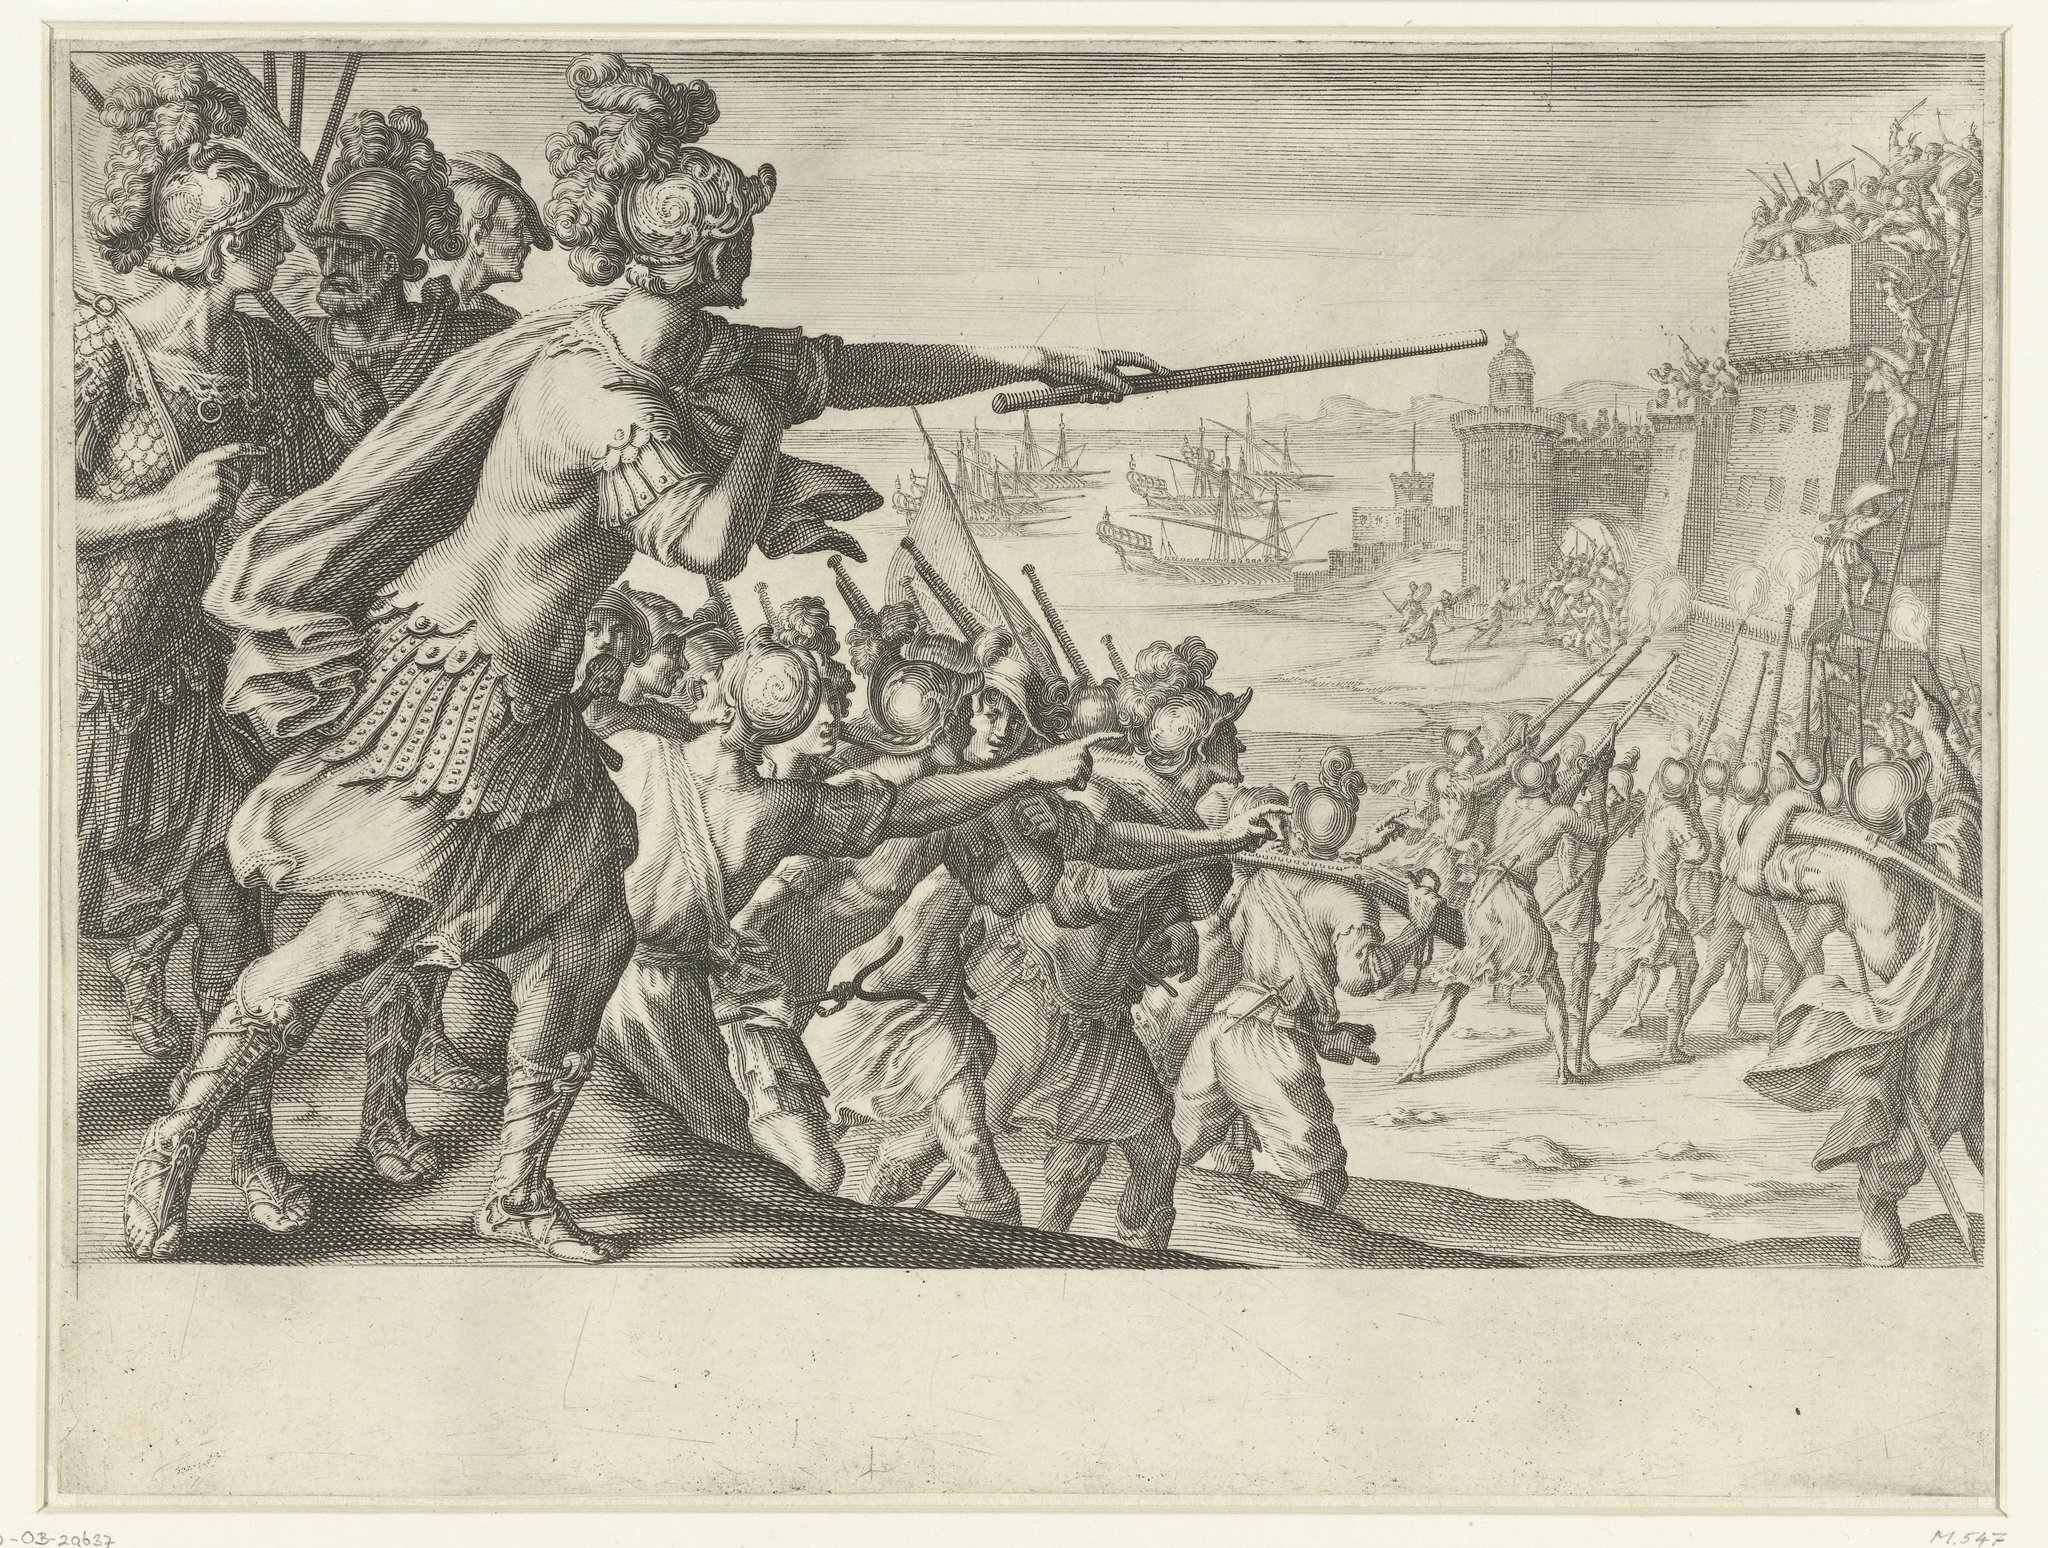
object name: print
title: Aanval van de troepen van Ferdinando I de' Medici op de Noord-Afrikaanse stad Bone (Annaba)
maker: jacques callot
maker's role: draughtsman, print maker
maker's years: 1592-1635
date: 1614-1620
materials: paper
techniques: engraving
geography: florence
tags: ferdinando i de' medici, asiatic races and peoples: turks, walls ~ fortified city, (military) attack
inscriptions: collector's mark: Lugt 240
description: De aanvoerder van de troepen van Ferdinando I de' Medici, links op de voorgrond, wijst met zijn aanvoerdersstaf naar een stadsmuur, die bestormd wordt door zijn manschappen. Onder de voorstelling een lege marge. Deze prent is onderdeel van een serie van 16 prenten (plus 2 onvoltooide prenten) van het leven van Ferdinando I de' Medici, bedoeld geweest als aanvulling op een reeds bestaande reeks illustraties van de geschiedenis van de Medicis.